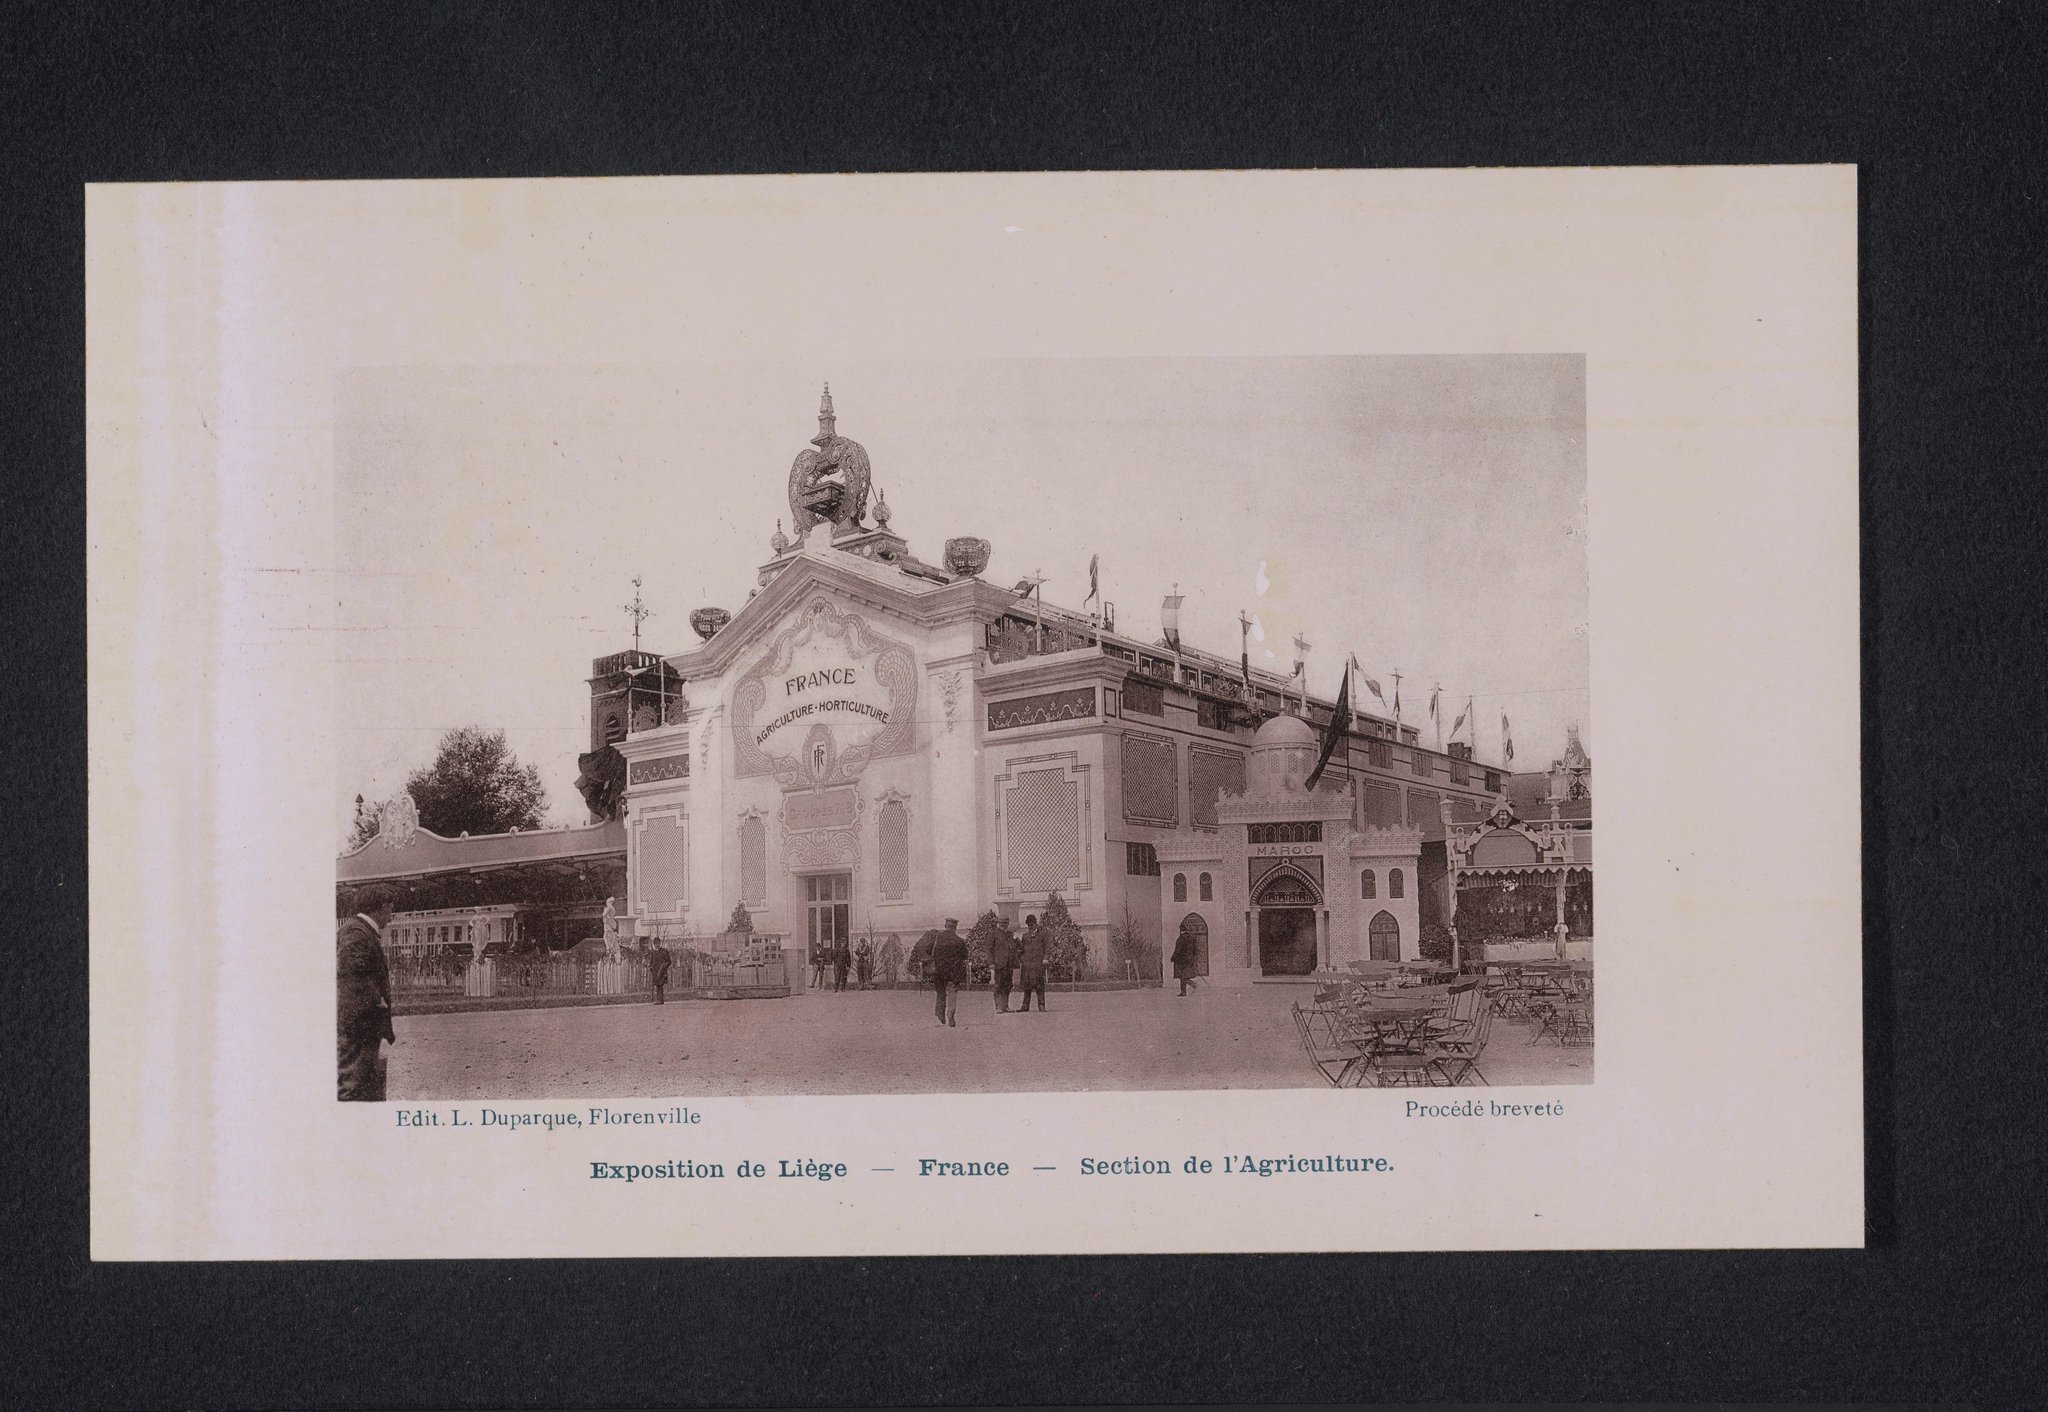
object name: photomechanical print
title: Exposition de Liège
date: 1905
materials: paper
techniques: photograph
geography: florenville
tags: world fair, world exhibition, agriculture, cattle-breeding, horticulture, flowerculture, etc., liège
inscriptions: inscription: ‘Procédé breveté’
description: Deze prent maakt deel uit van een omslag met 16 prenten.